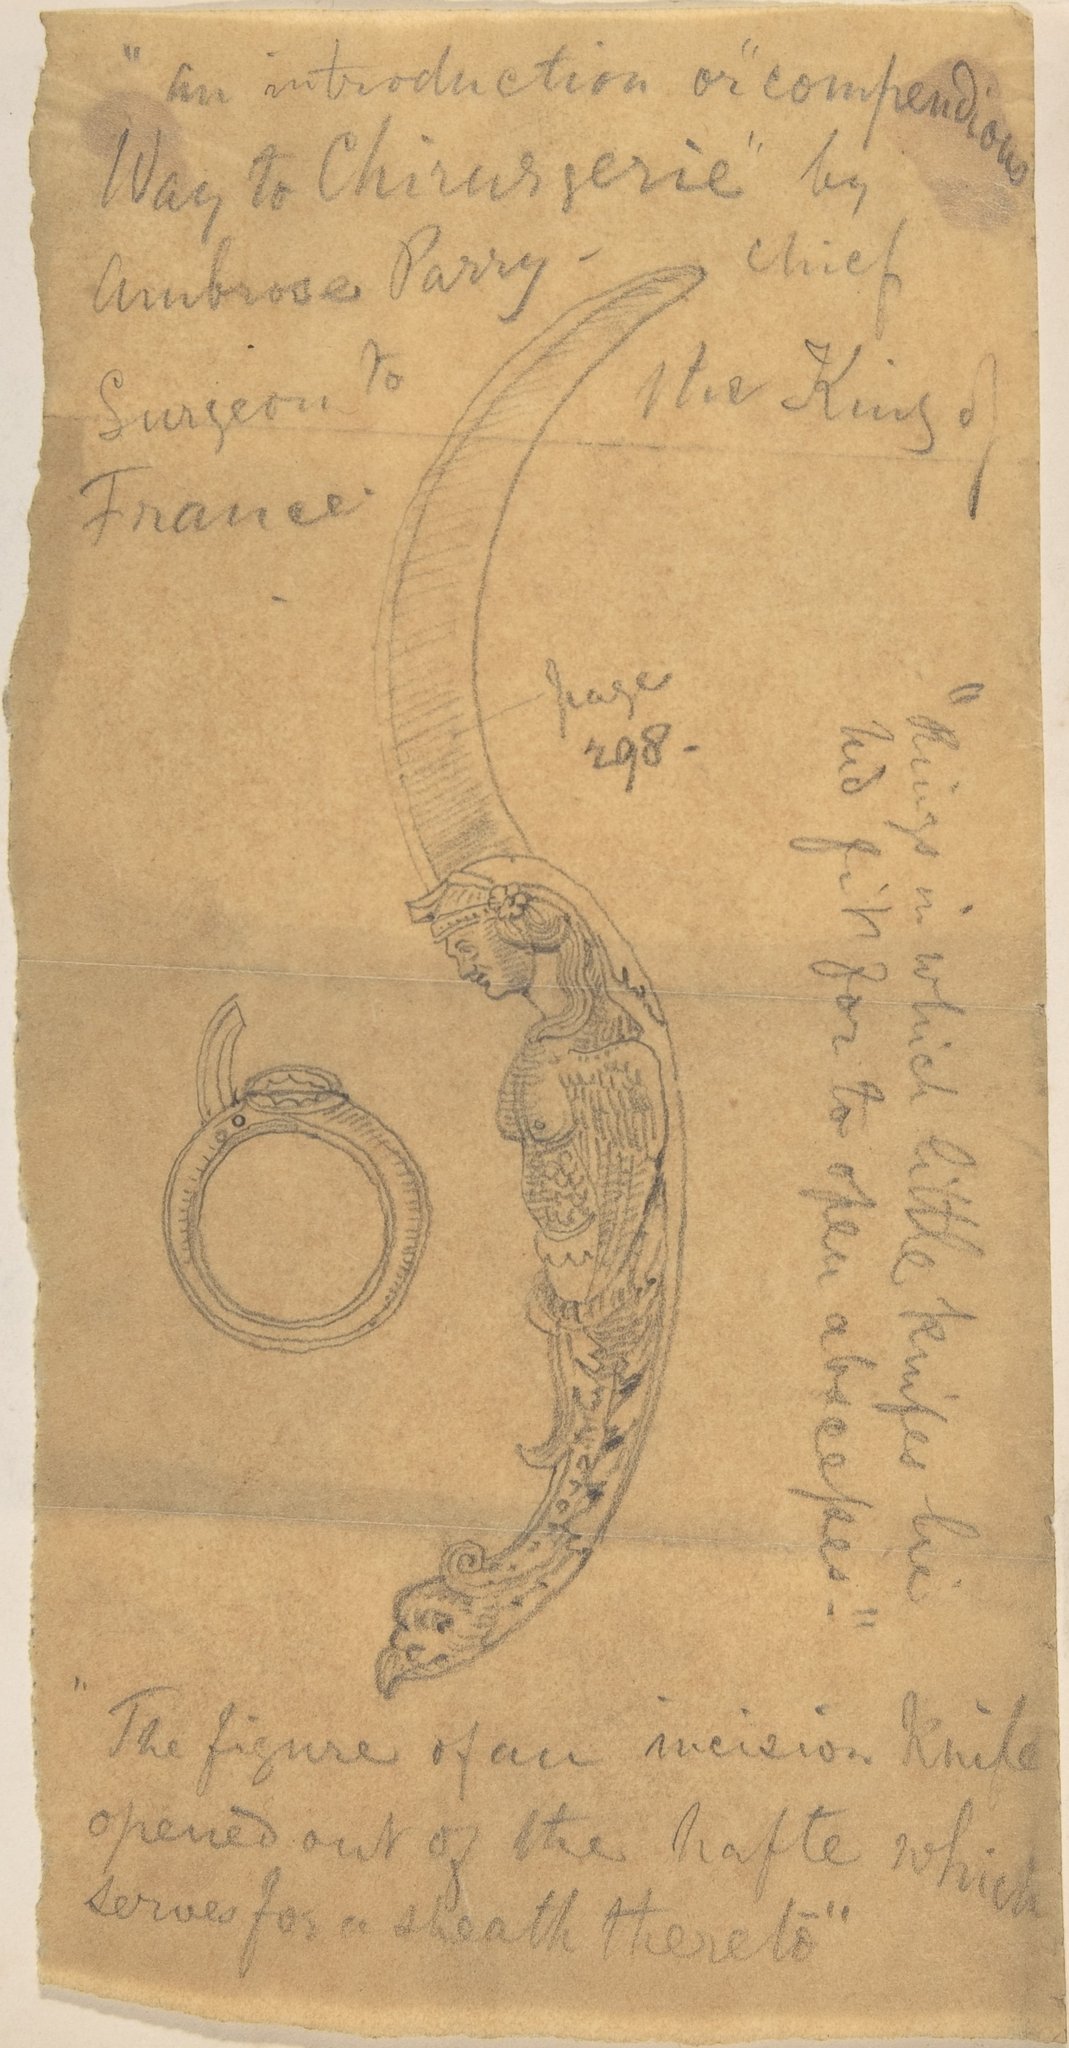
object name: drawing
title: Knife with Ornamental Handle, from the Way to Chirurgerie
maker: anonymous, british, 19th century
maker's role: artist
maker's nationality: british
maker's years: 1800-1900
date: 1851-1900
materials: graphite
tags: knives,ornament